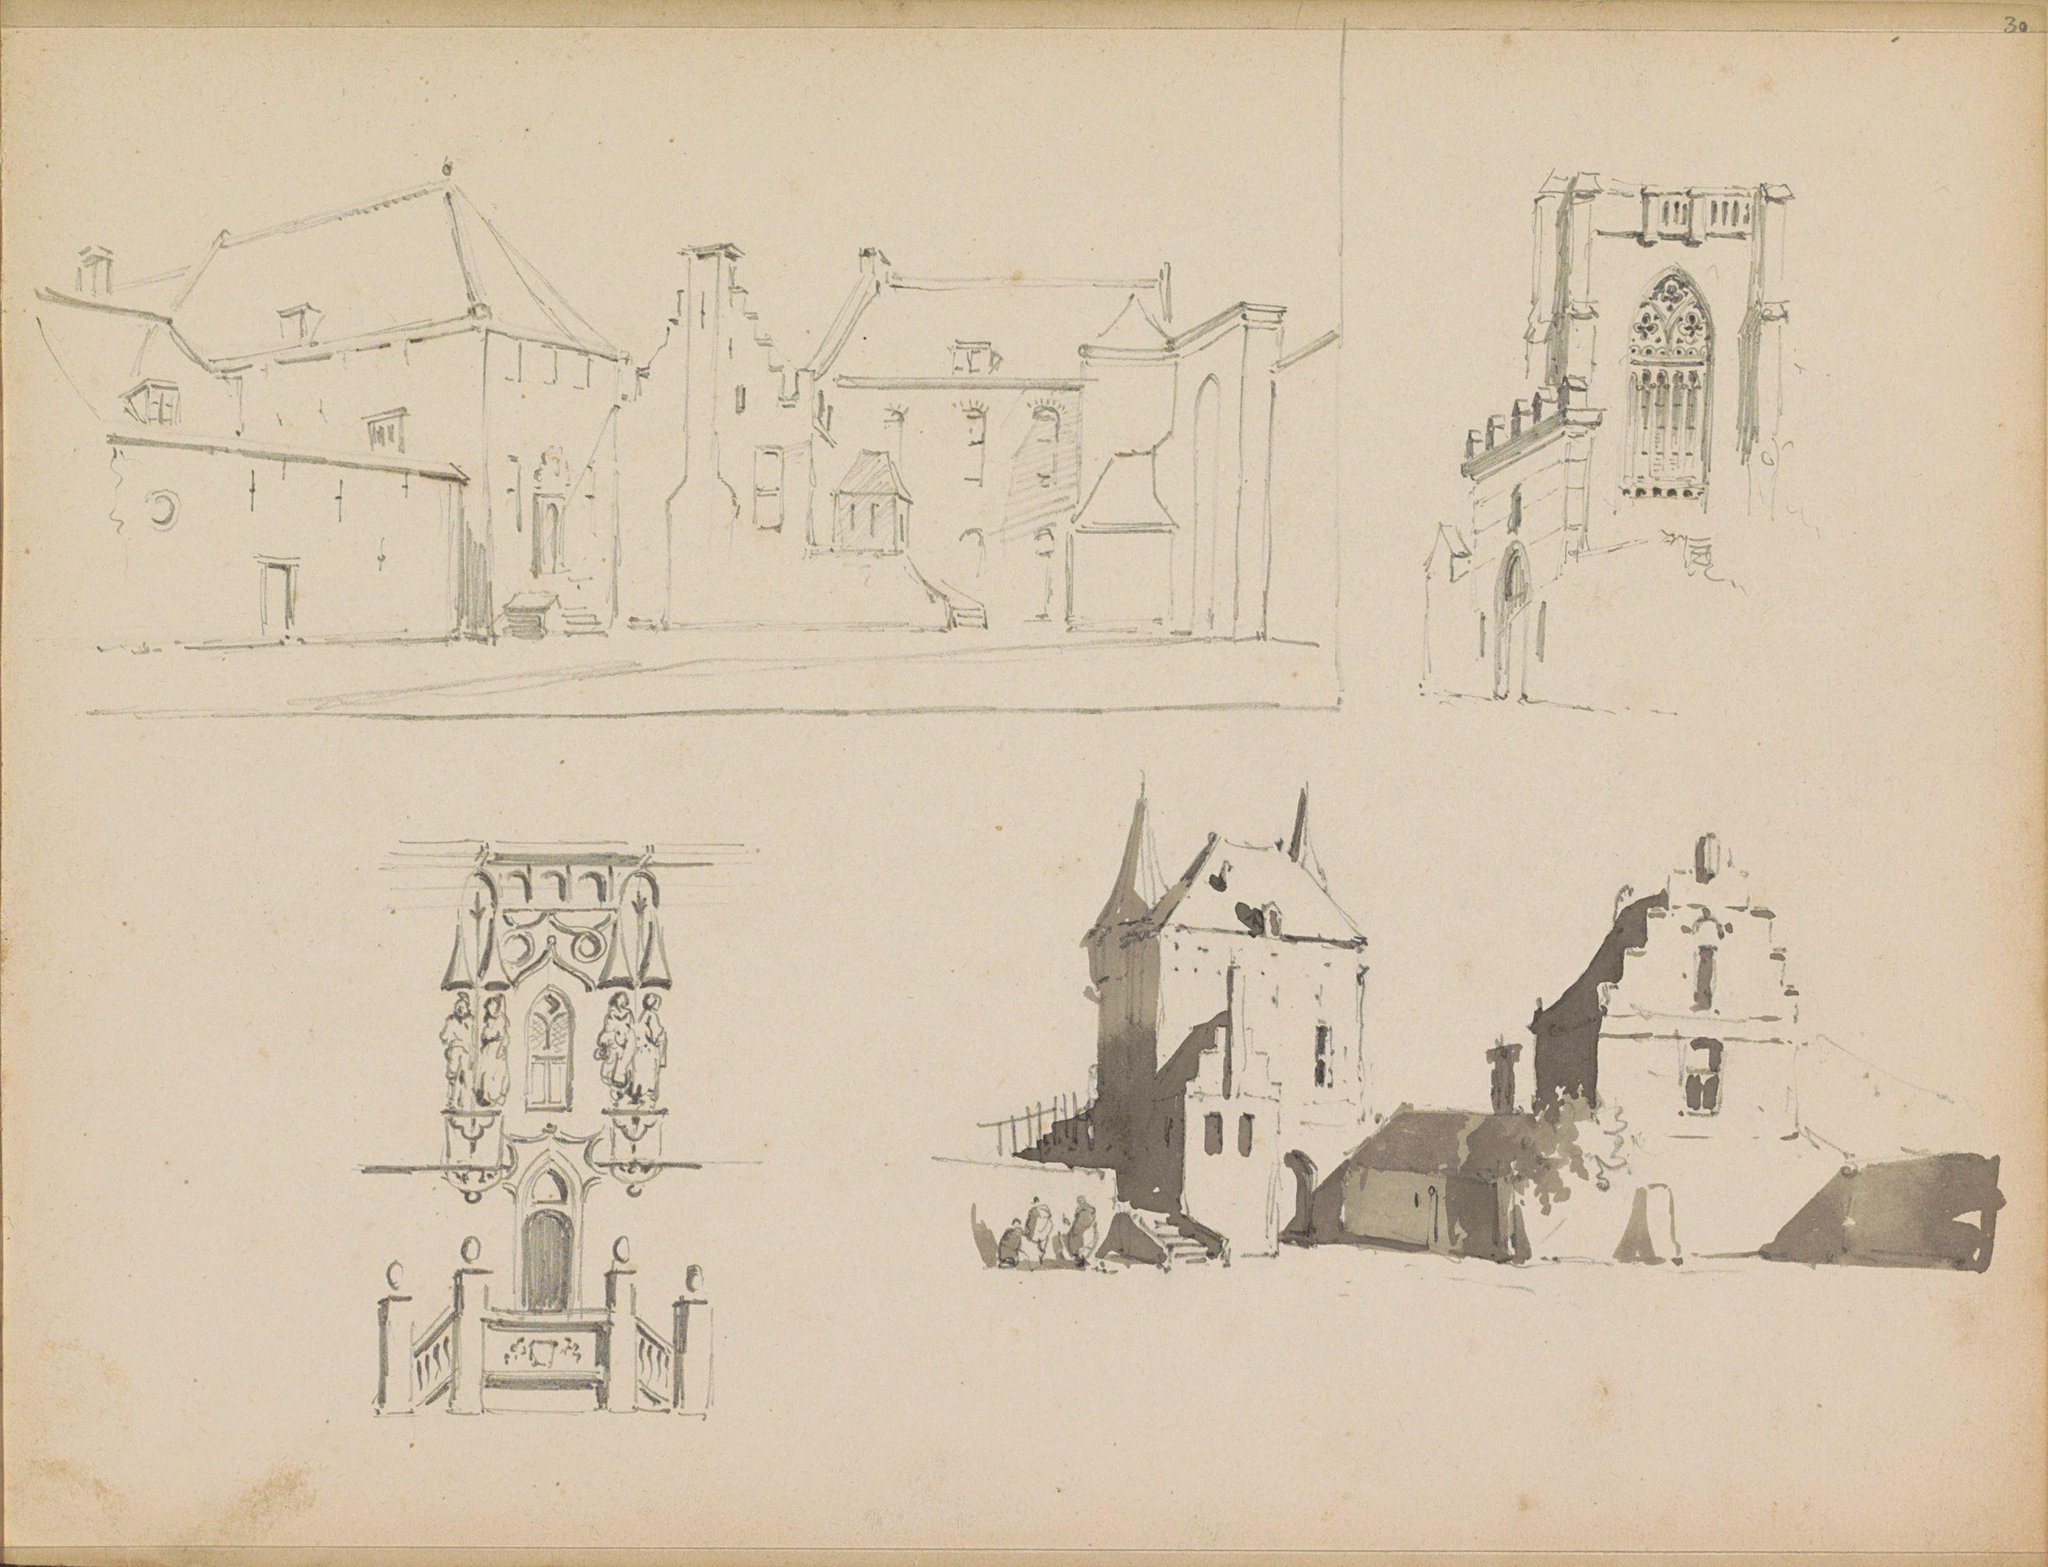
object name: sketchbook leaf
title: Studieblad met gebouwen en een stadsgezicht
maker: adrianus eversen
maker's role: draughtsman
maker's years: 1818-1897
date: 1828-1897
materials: paper, pencil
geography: netherlands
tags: city-view, and landscape with man-made constructions, civic architecture; edifices; dwellings, city-gate, tower (of house or building)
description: Linksboven een stadsgezicht. Rechtsboven een toren met een spitsboogvenster, mogelijk van een kerk. Linksonder een bordes voor een gevel met sculpturen. Rechtsonder een stadsgezicht met een poort en een gebouw met een trapgevel. Blad 30 uit een schetsboek met 41 bladen.